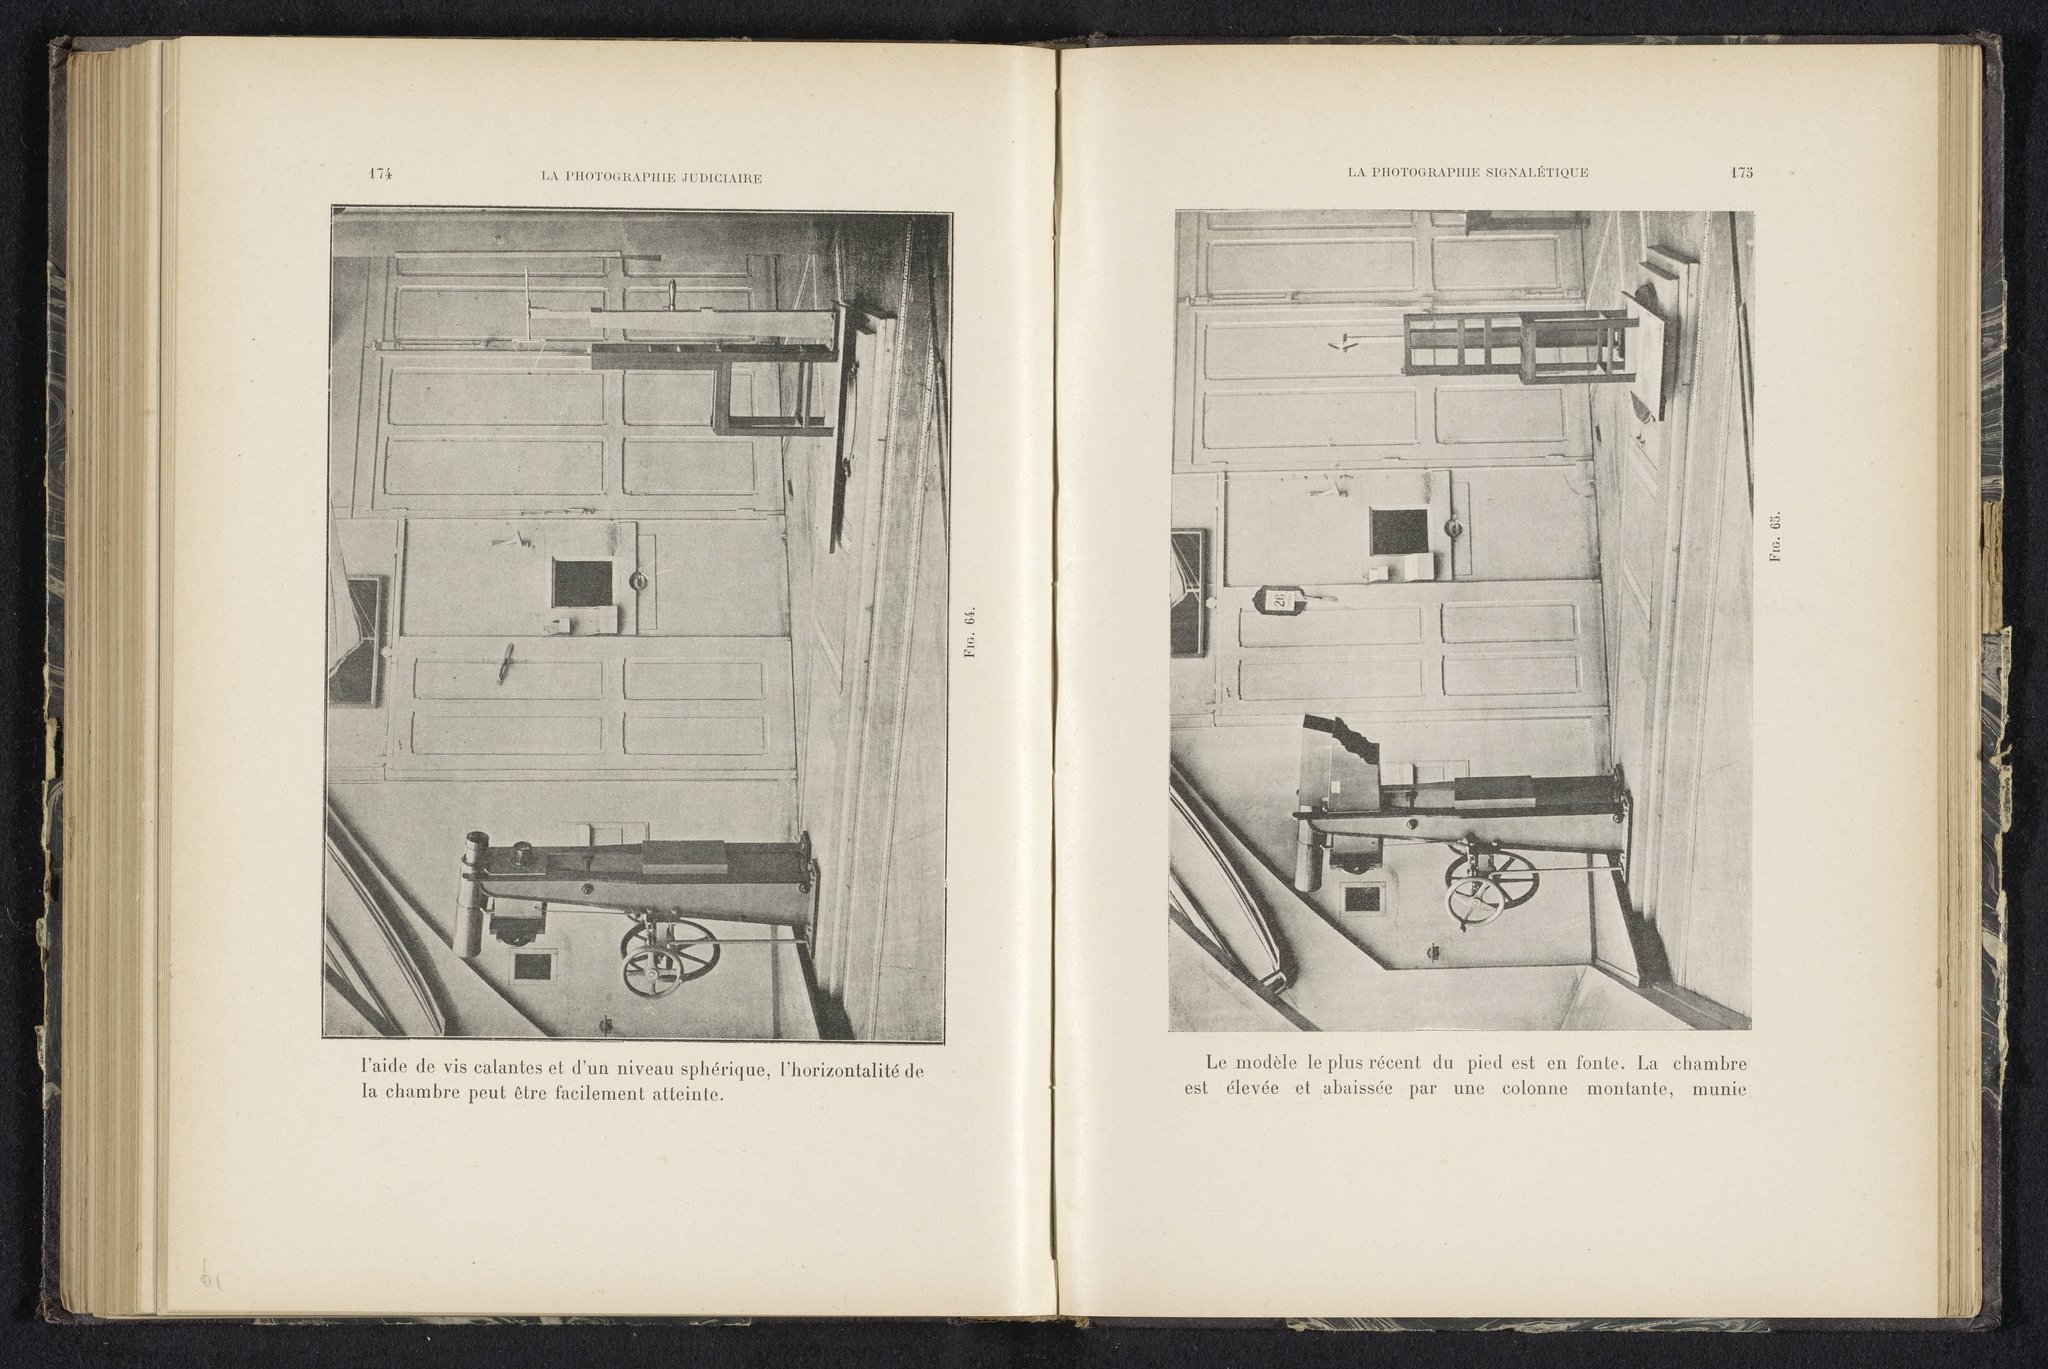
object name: photomechanical print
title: Opstelling voor het fotograferen van criminelen volgens de methode van Bertillon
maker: Anonymous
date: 1893-1903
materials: paper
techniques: autotype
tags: studio ~ photographer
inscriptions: number: ‘Fig. 65.’